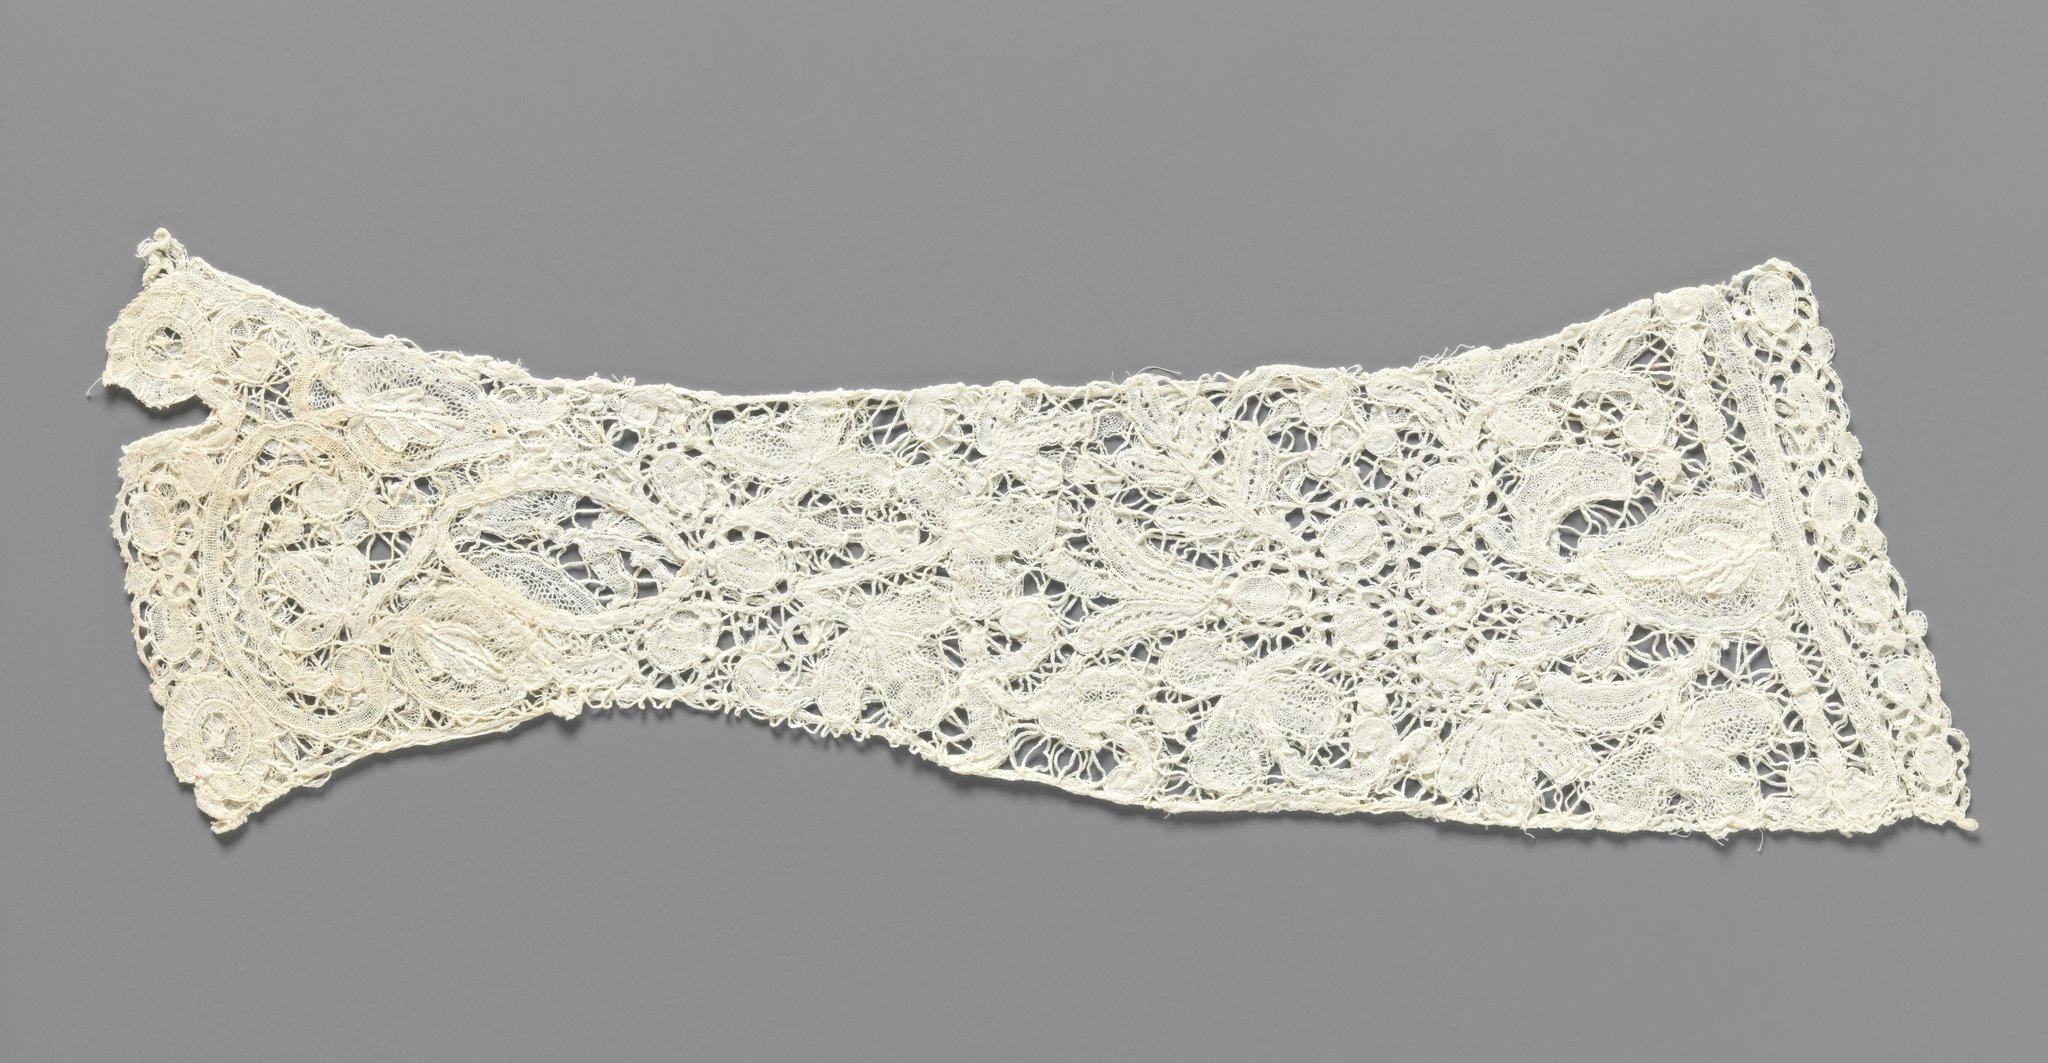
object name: mitt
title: Mitaine van kloskant met c-voluten met zigzag-lijnen en hartvormige bladeren met een dubbel hart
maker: Anonymous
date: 1850-1899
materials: linen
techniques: lace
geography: belgium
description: Mitaine van naturelkleurige kloskant: fijn Brugs bloemwerk. Het patroon bestaat langs de rand bij het gedeelte waar de hand uit de mitaine steekt aan de voor- en achterzijde uit een c-voluut waaruit twee hartvormige bladeren ontspringen. Het hart van deze bladeren is dubbellaags, gemaakt met een applicatie van kloskant. In elke voluut een zigzag-lijn en parelrand. Deze zigzag met parelrand komt terug langs de rand aan de onderzijde. Het overige patroon bestaat onder andere uit ranken met driedubbele bladeren en bloemen met een dichtgewerkt ovaal bloemhart en opengewerkte ovale bloemblaadjes. Met deze bloemen zijn boven- en onderrand van de mitaine afgewerkt. De motieven zijn gemaakt in linnenslag en netslag met dikke contourdraden en reliëfcontouren. De motieven zijn met elkaar verbonden door een vlechtengrond. In een enkele rozetbloem is in het bloemhart een blokje gespannen, gemaakt in vormslag.